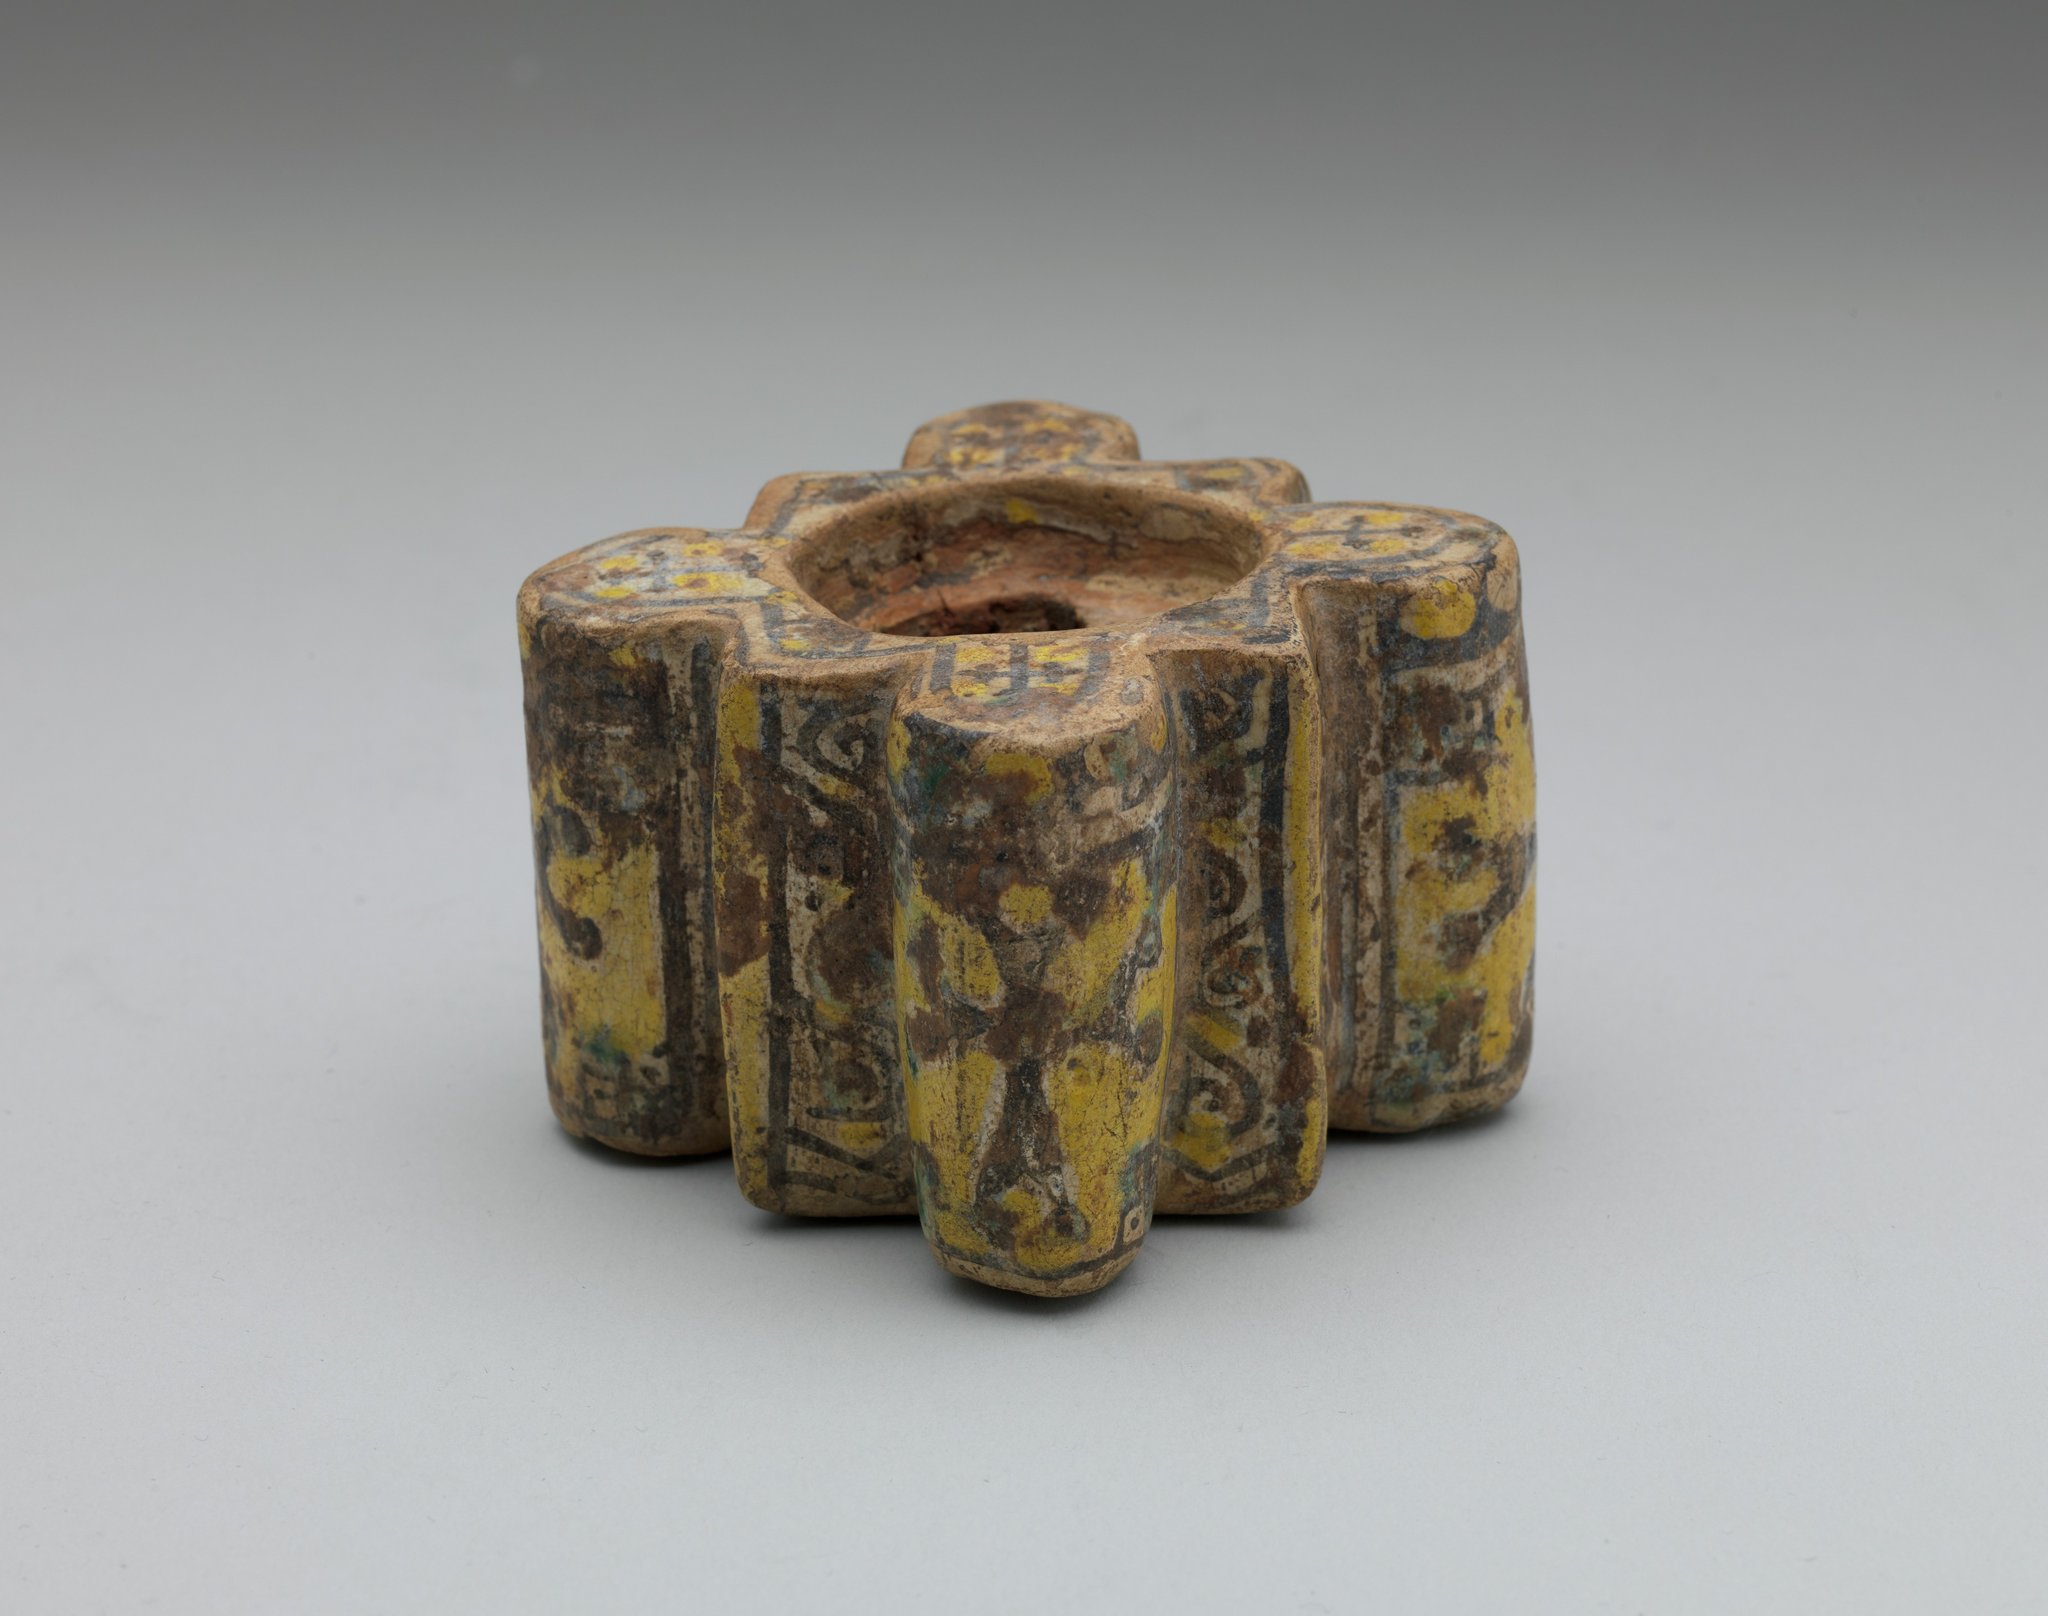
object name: inkwell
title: Inkwell with Crosses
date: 901-1000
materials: earthenware, glaze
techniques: polychrome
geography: iran